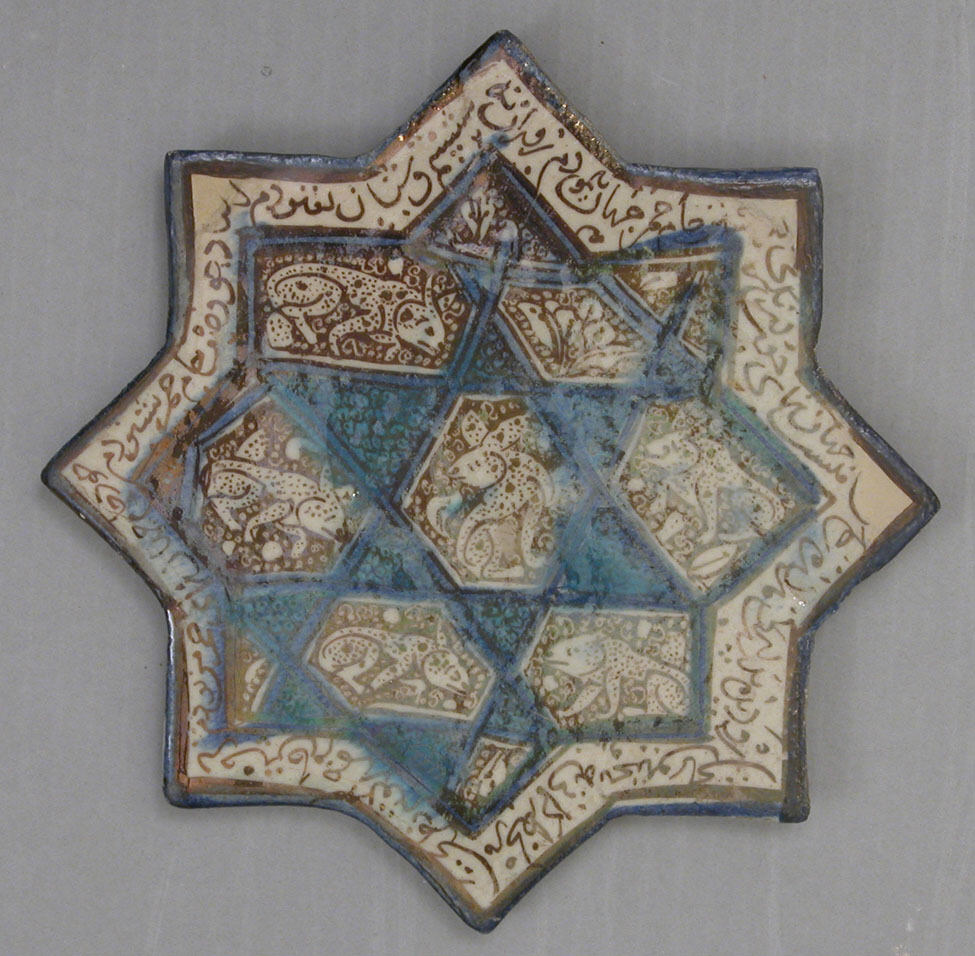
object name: tile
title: Star-Shaped Tile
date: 1301-1400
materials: stonepaste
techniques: painting, underglaze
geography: iran